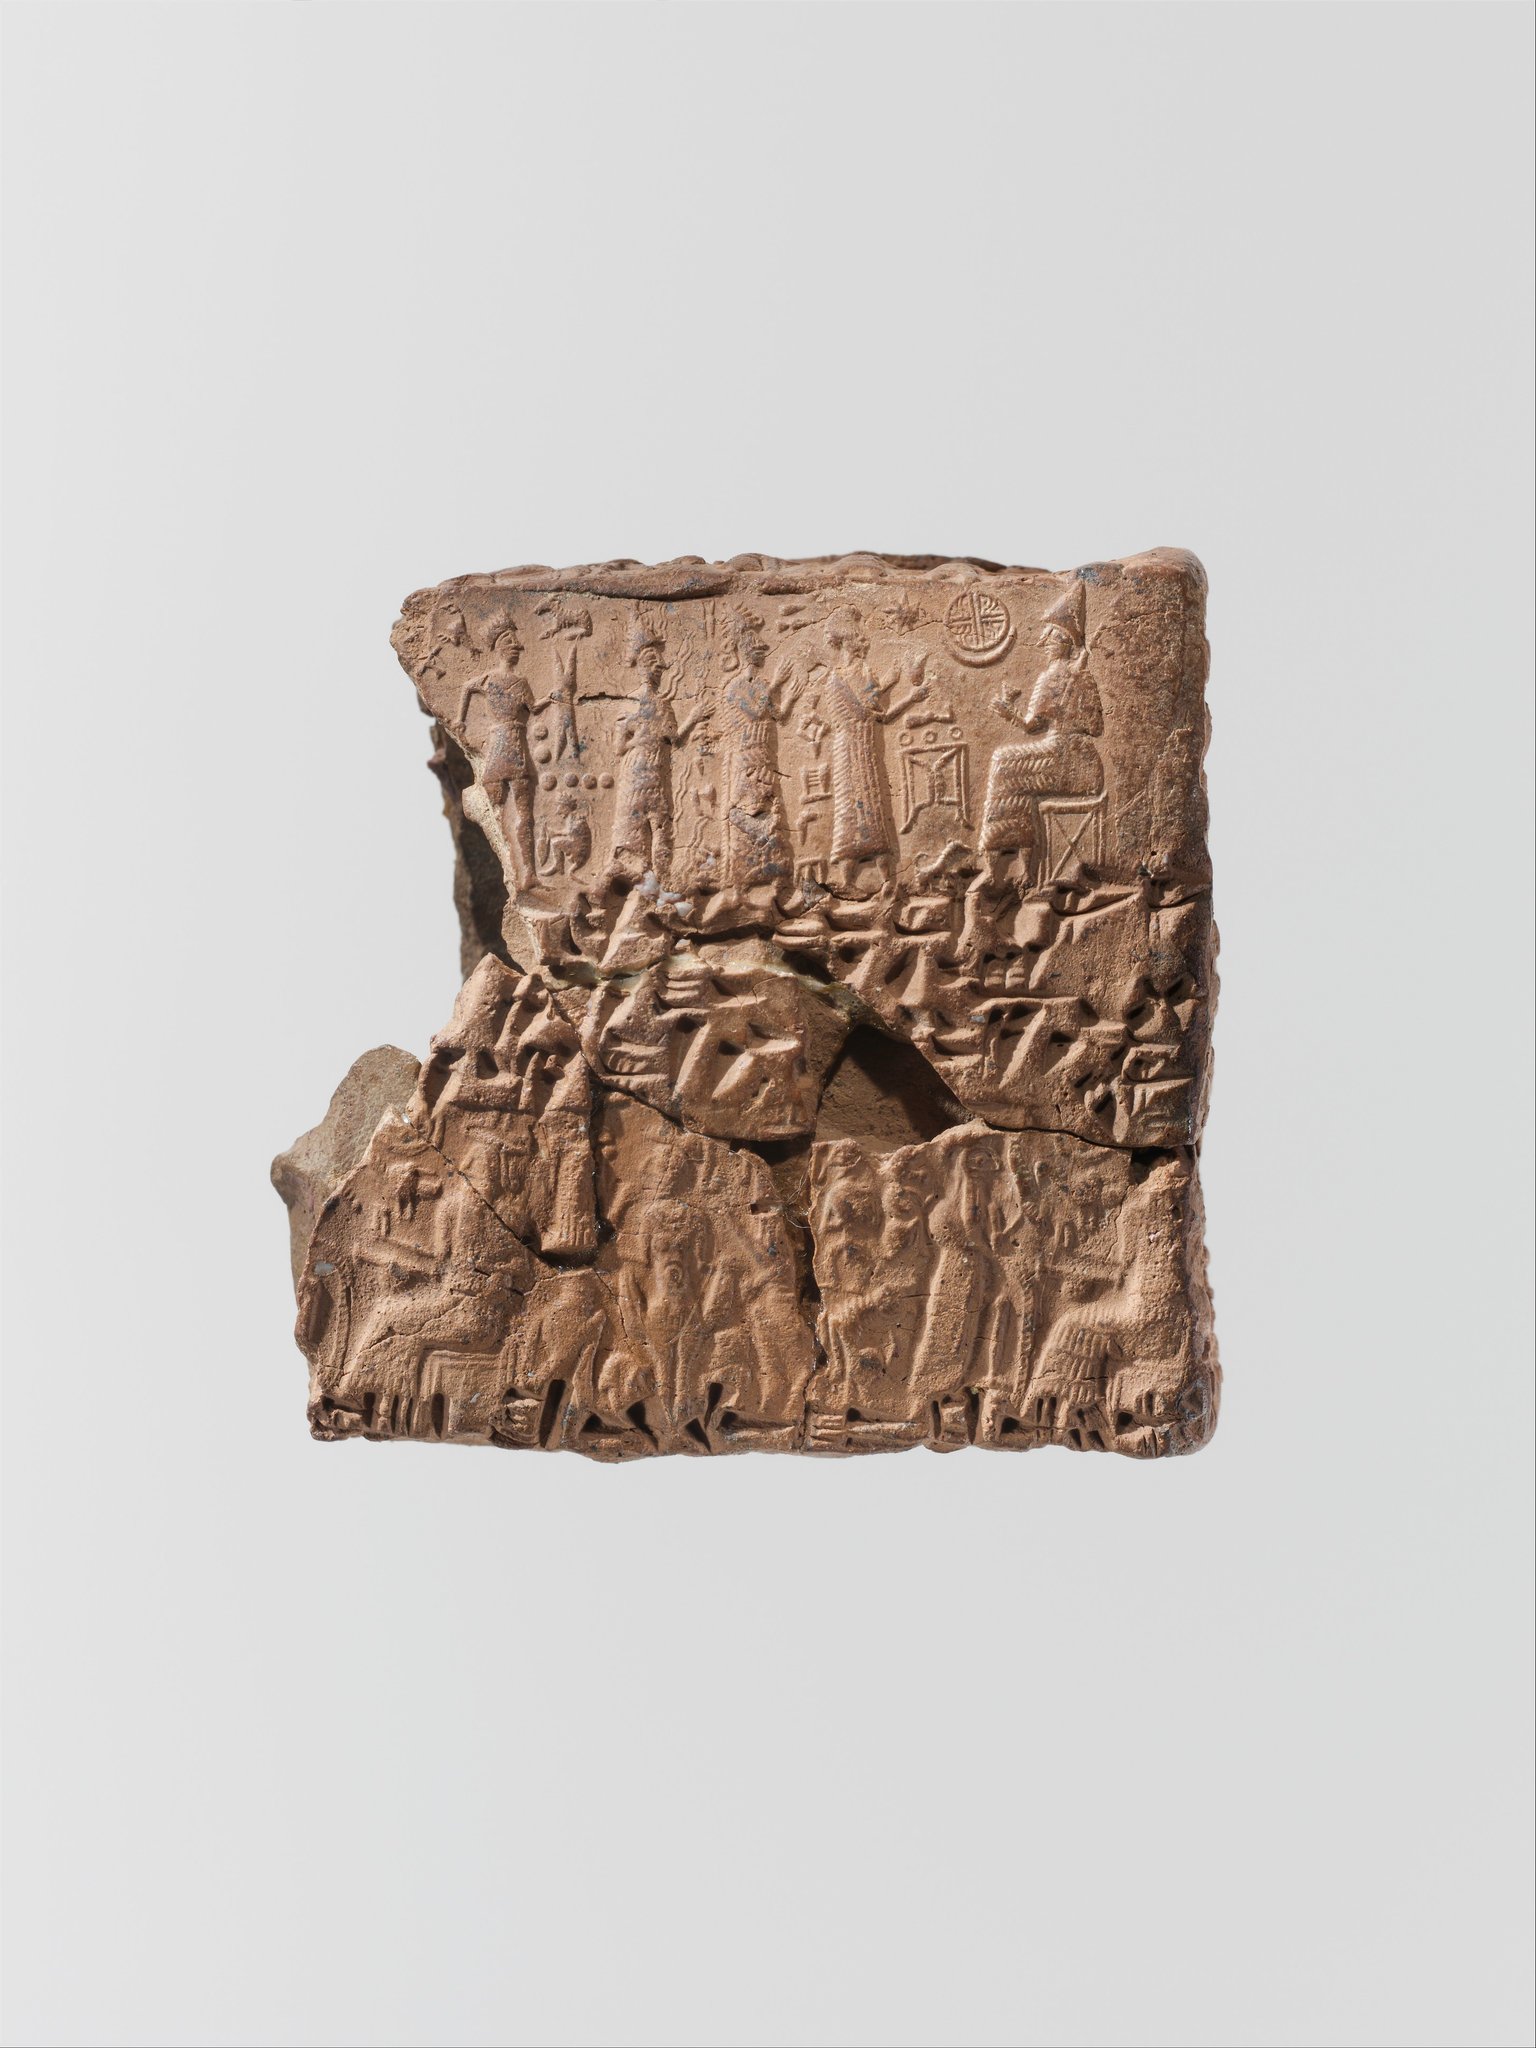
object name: cuneiform tablet case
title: Cuneiform tablet case impressed with four cylinder seals in Anatolian and Old Assyrian style, for cuneiform tablet 66.245.16a: quittance for a loan in silver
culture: assyrian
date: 2000-1801 BCE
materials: clay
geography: anatolia